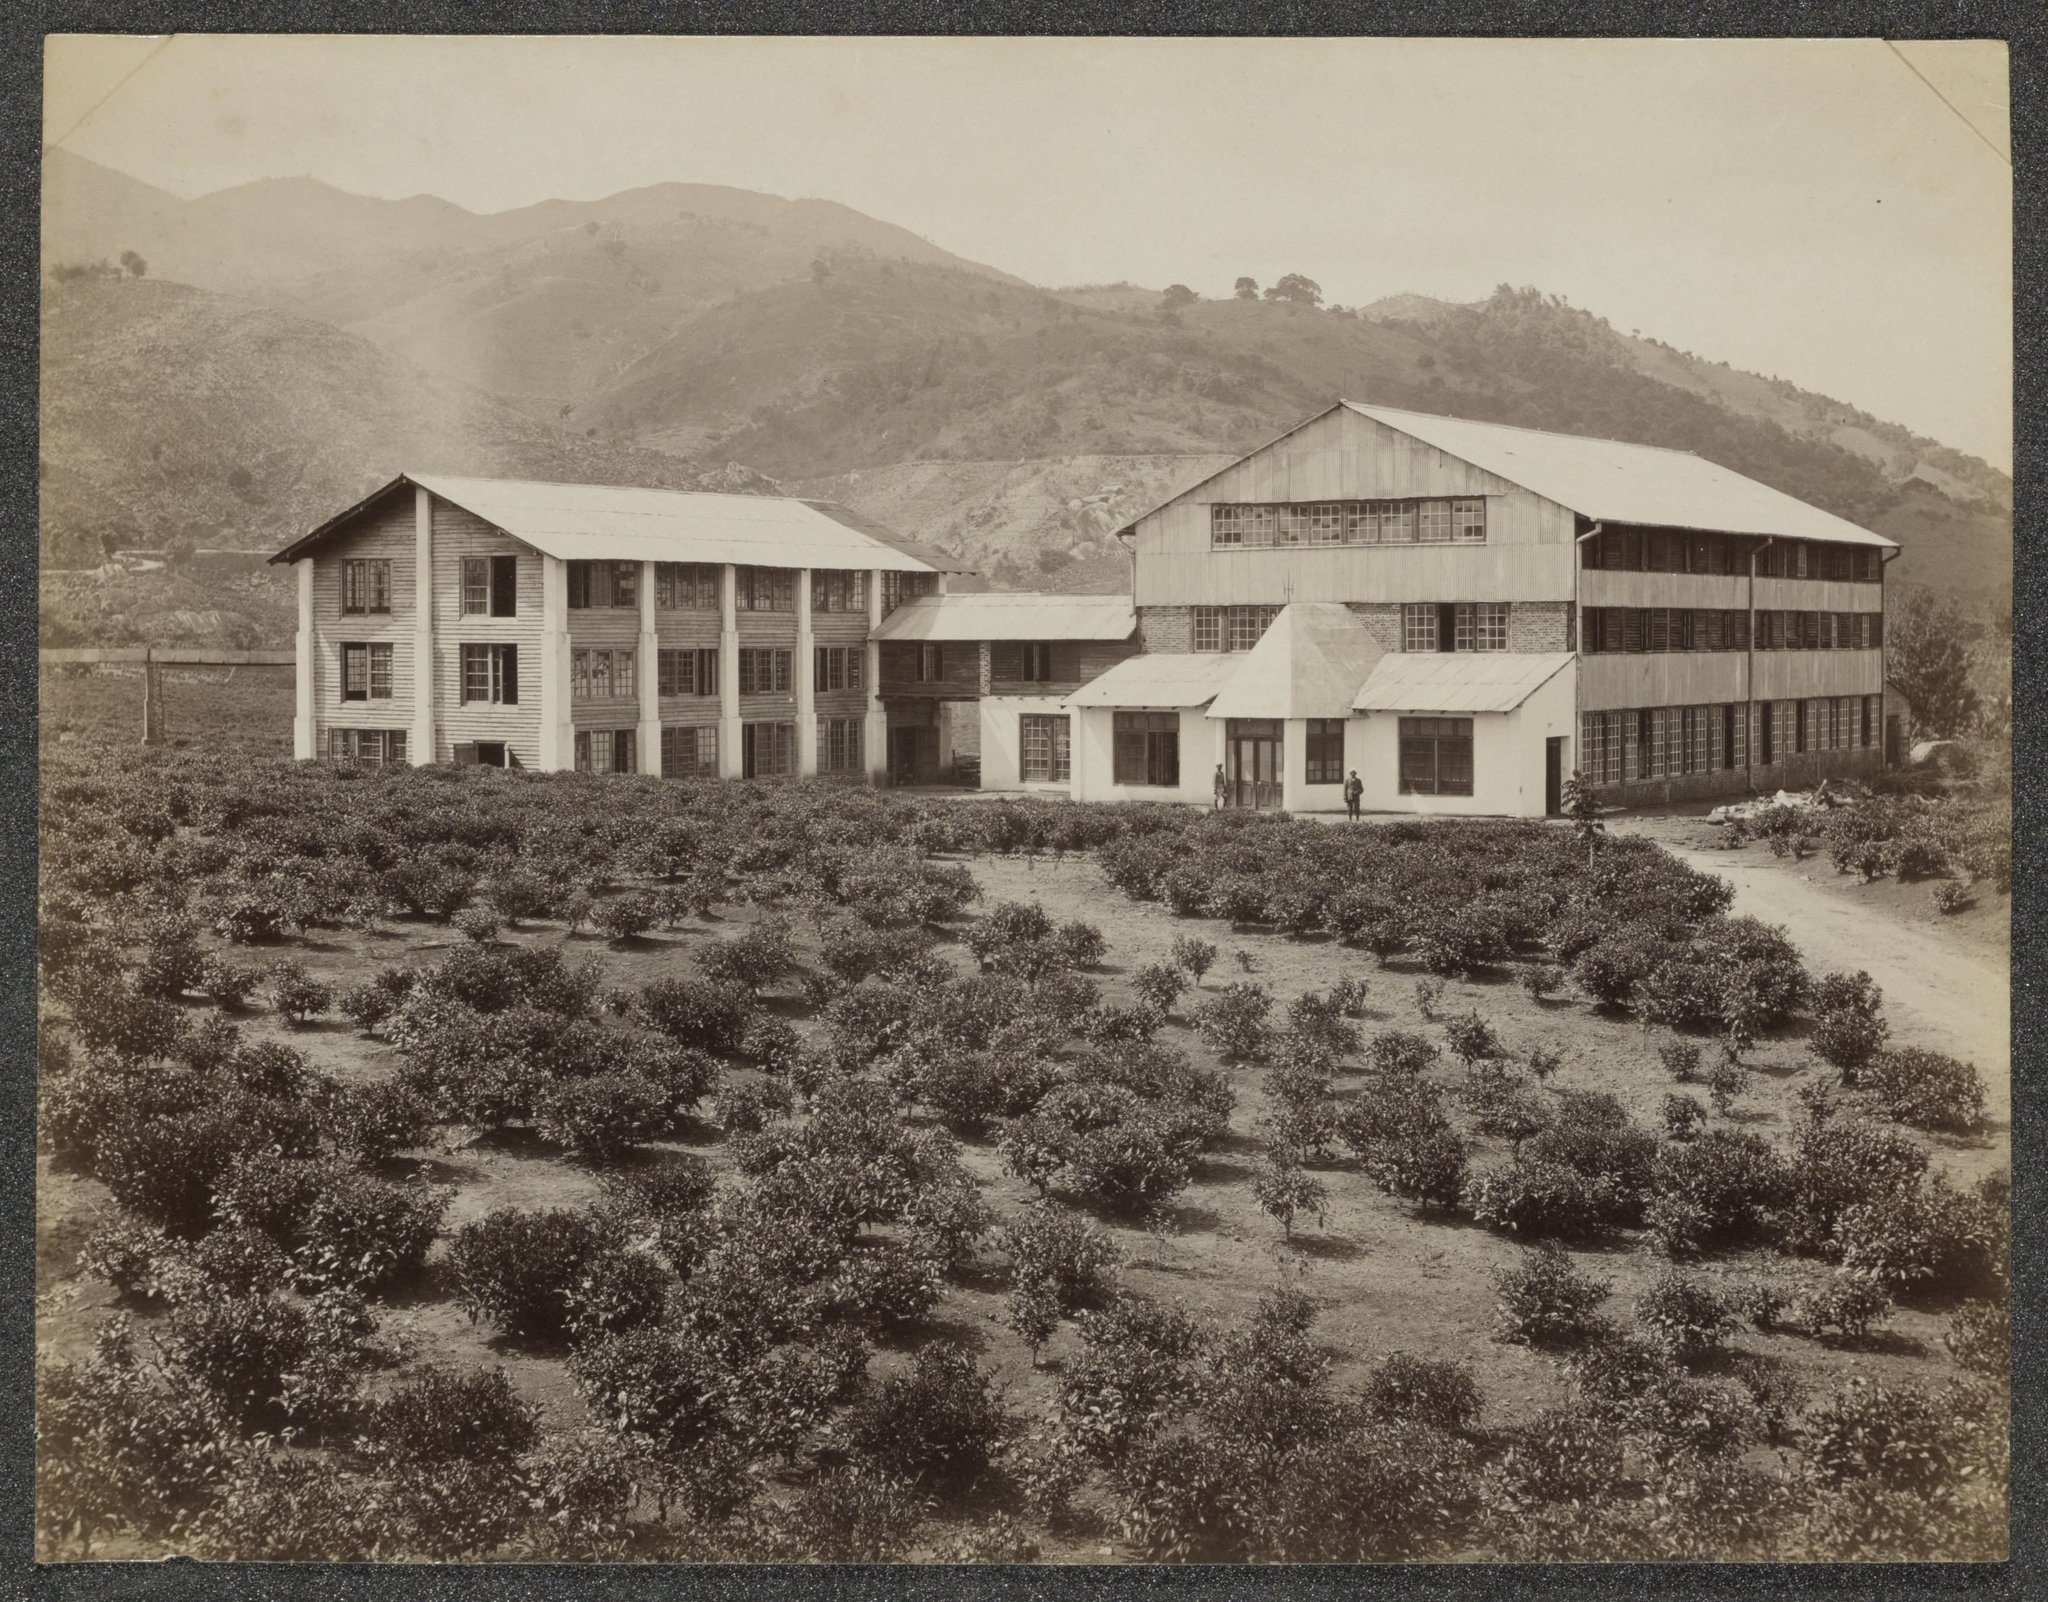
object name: photograph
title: Gezicht op gebouwen en plantage van de theefabriek Peradeniya op Ceylon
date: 1875-1880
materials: paper, photographic support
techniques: albumen print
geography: kandy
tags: plantation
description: Onderdeel van Album met 50 foto's van een reis door Zuidoost-Azië.